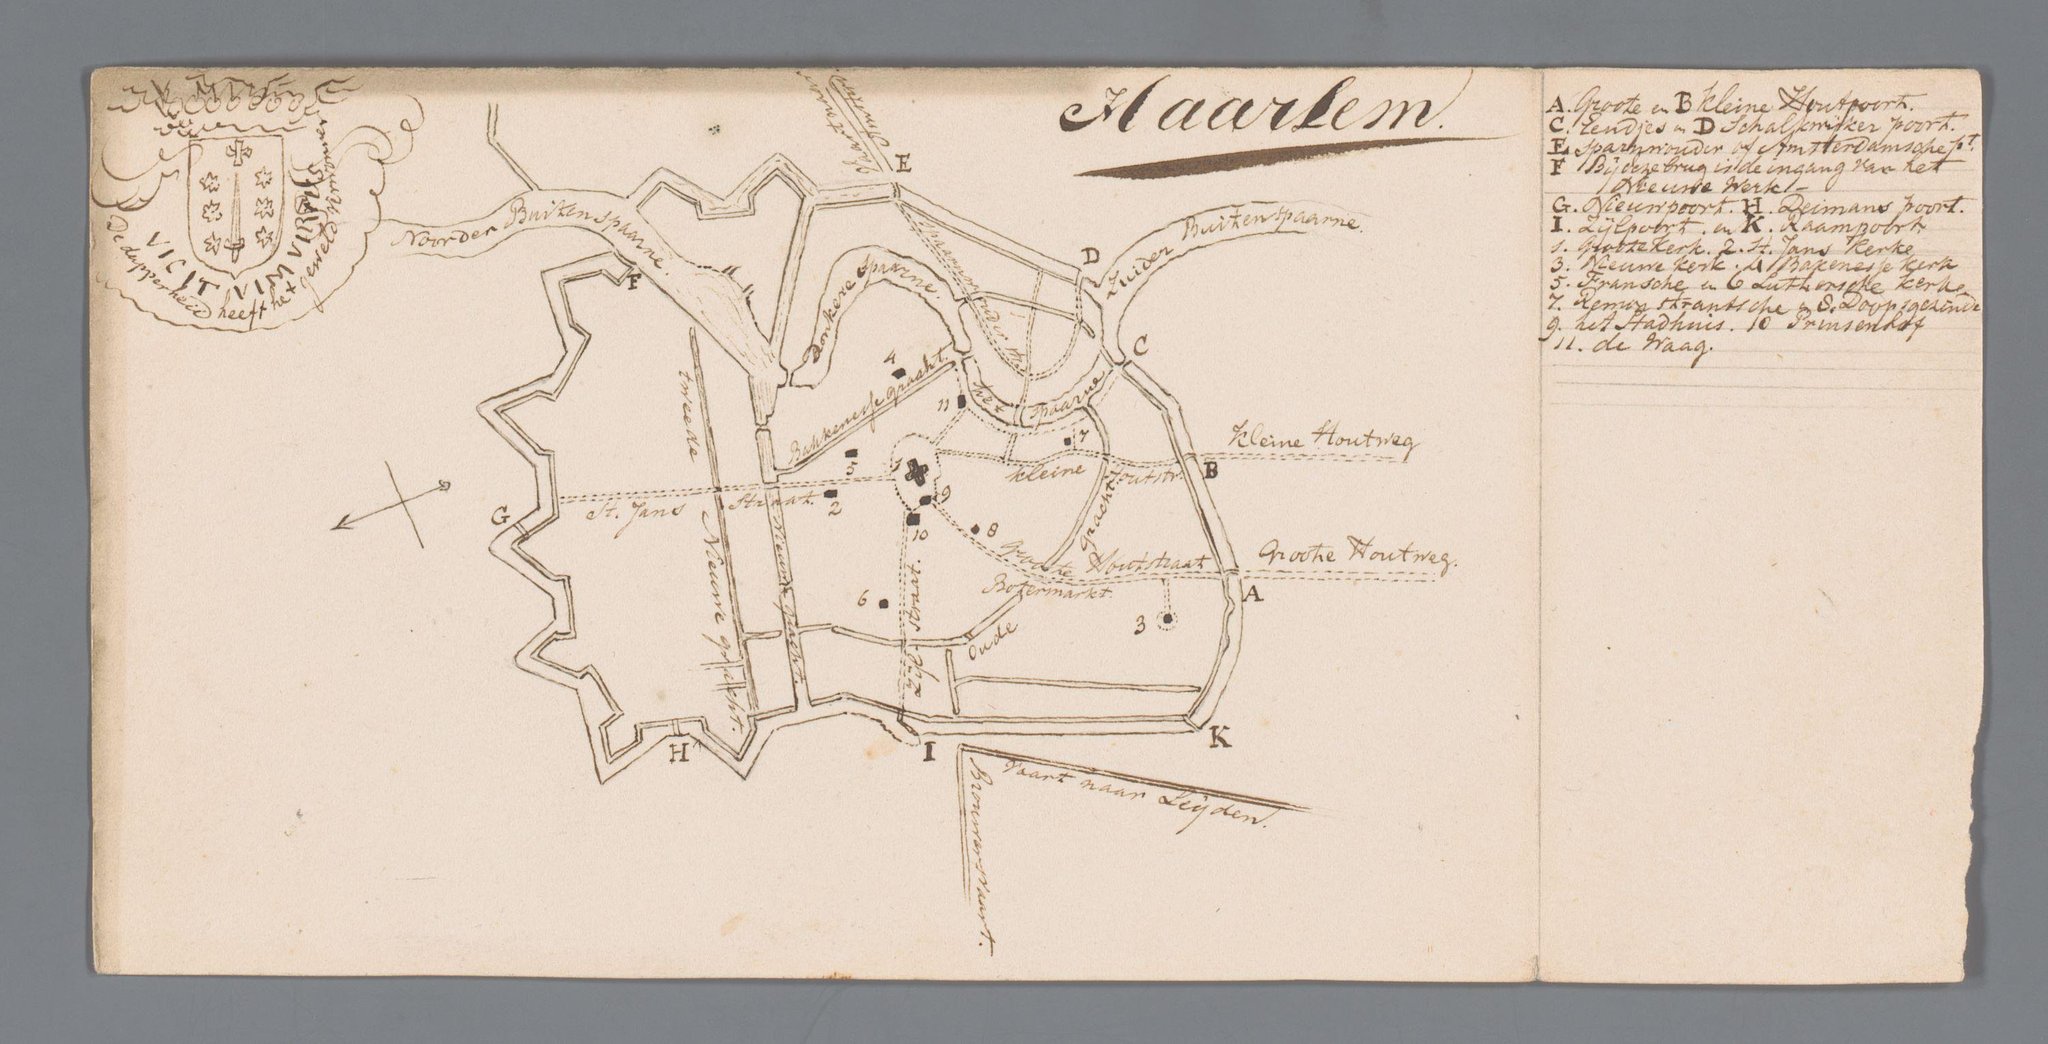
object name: area plan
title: Plattegrond van Haarlem met legenda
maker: Anonymous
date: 1700-1799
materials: ink, paper, pencil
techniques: pen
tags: maps of cities, haarlem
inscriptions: collector's mark: Lugt 2228a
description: Linksboven het stadswapen en motto van Haarlem